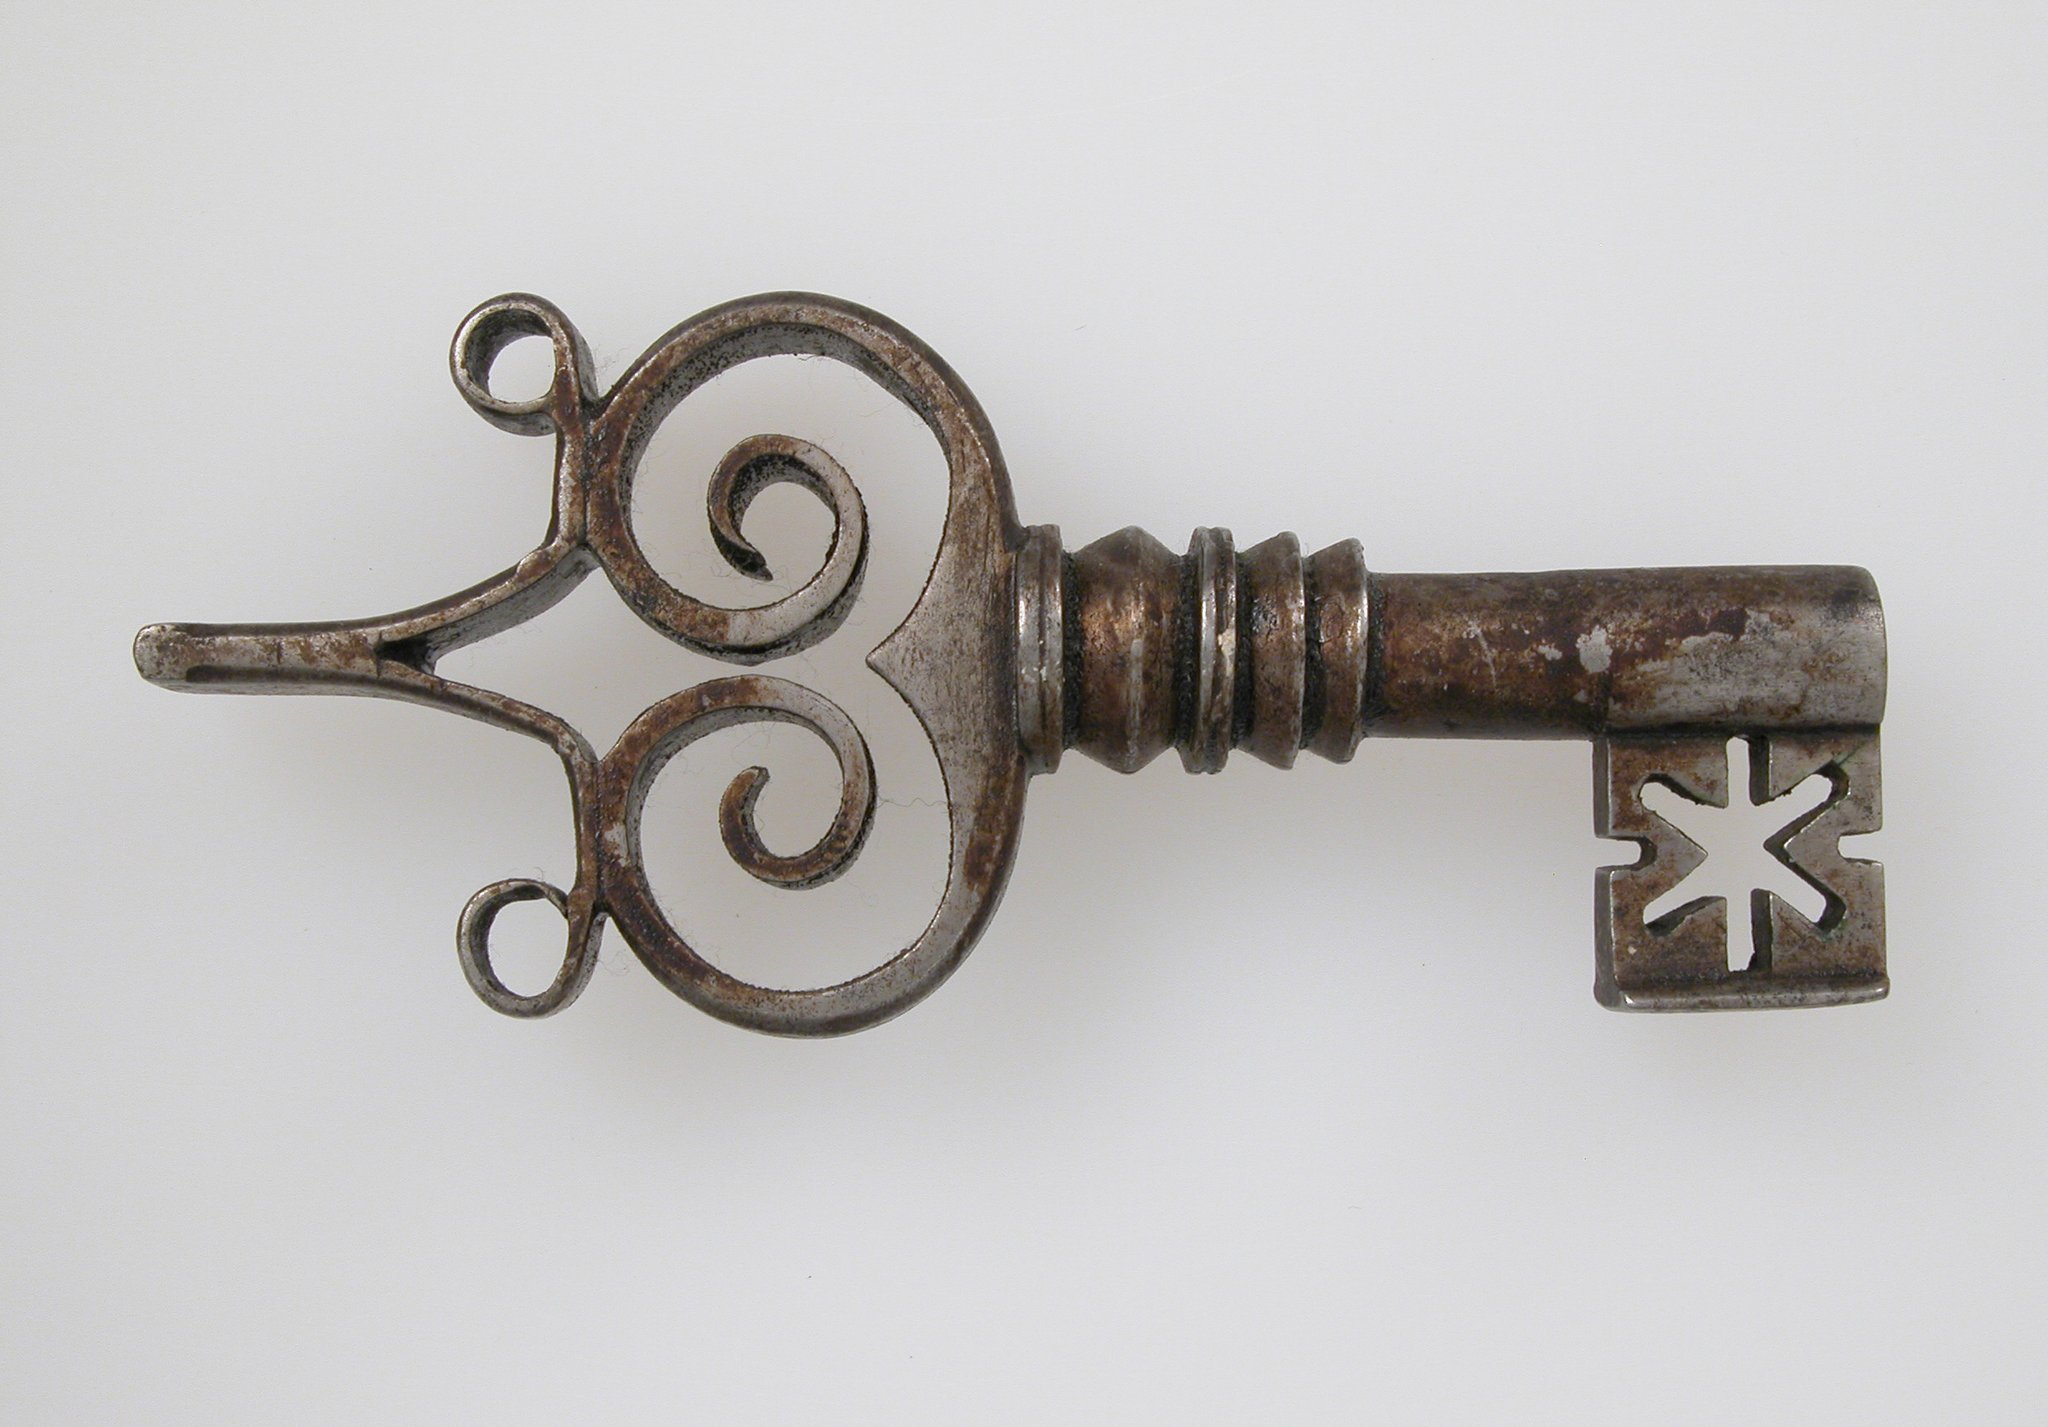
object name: key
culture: german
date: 1401-1500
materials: iron